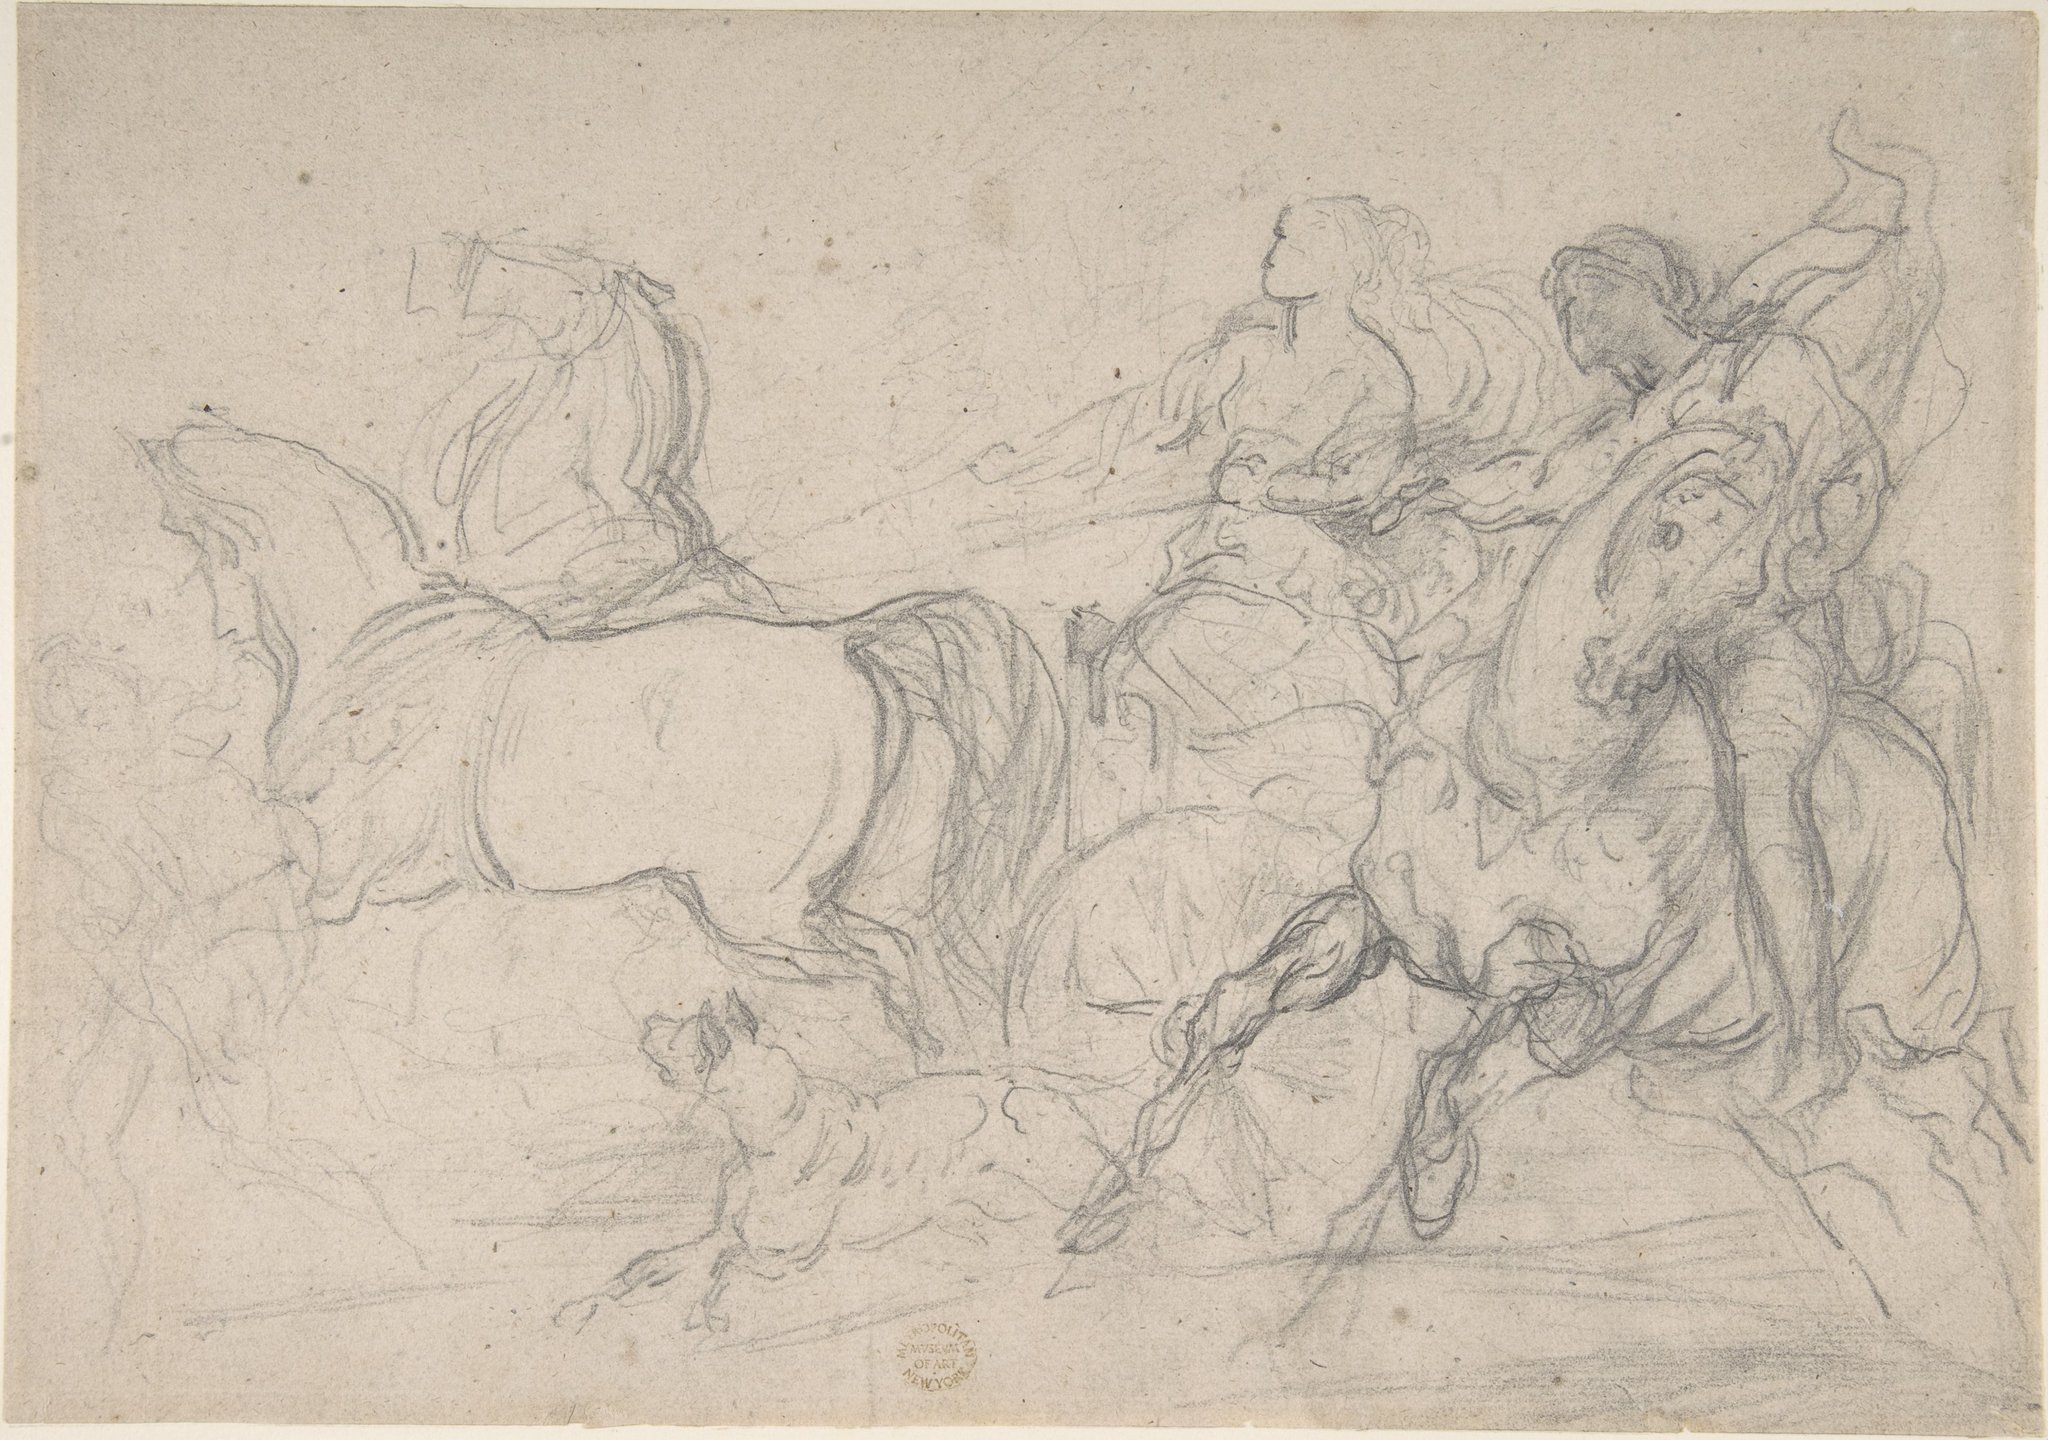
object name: drawing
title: Charioteer and Horseman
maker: jean louis andré théodore géricault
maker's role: artist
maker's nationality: french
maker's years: 1791-1824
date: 1801-1833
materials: graphite, paper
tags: men,horses